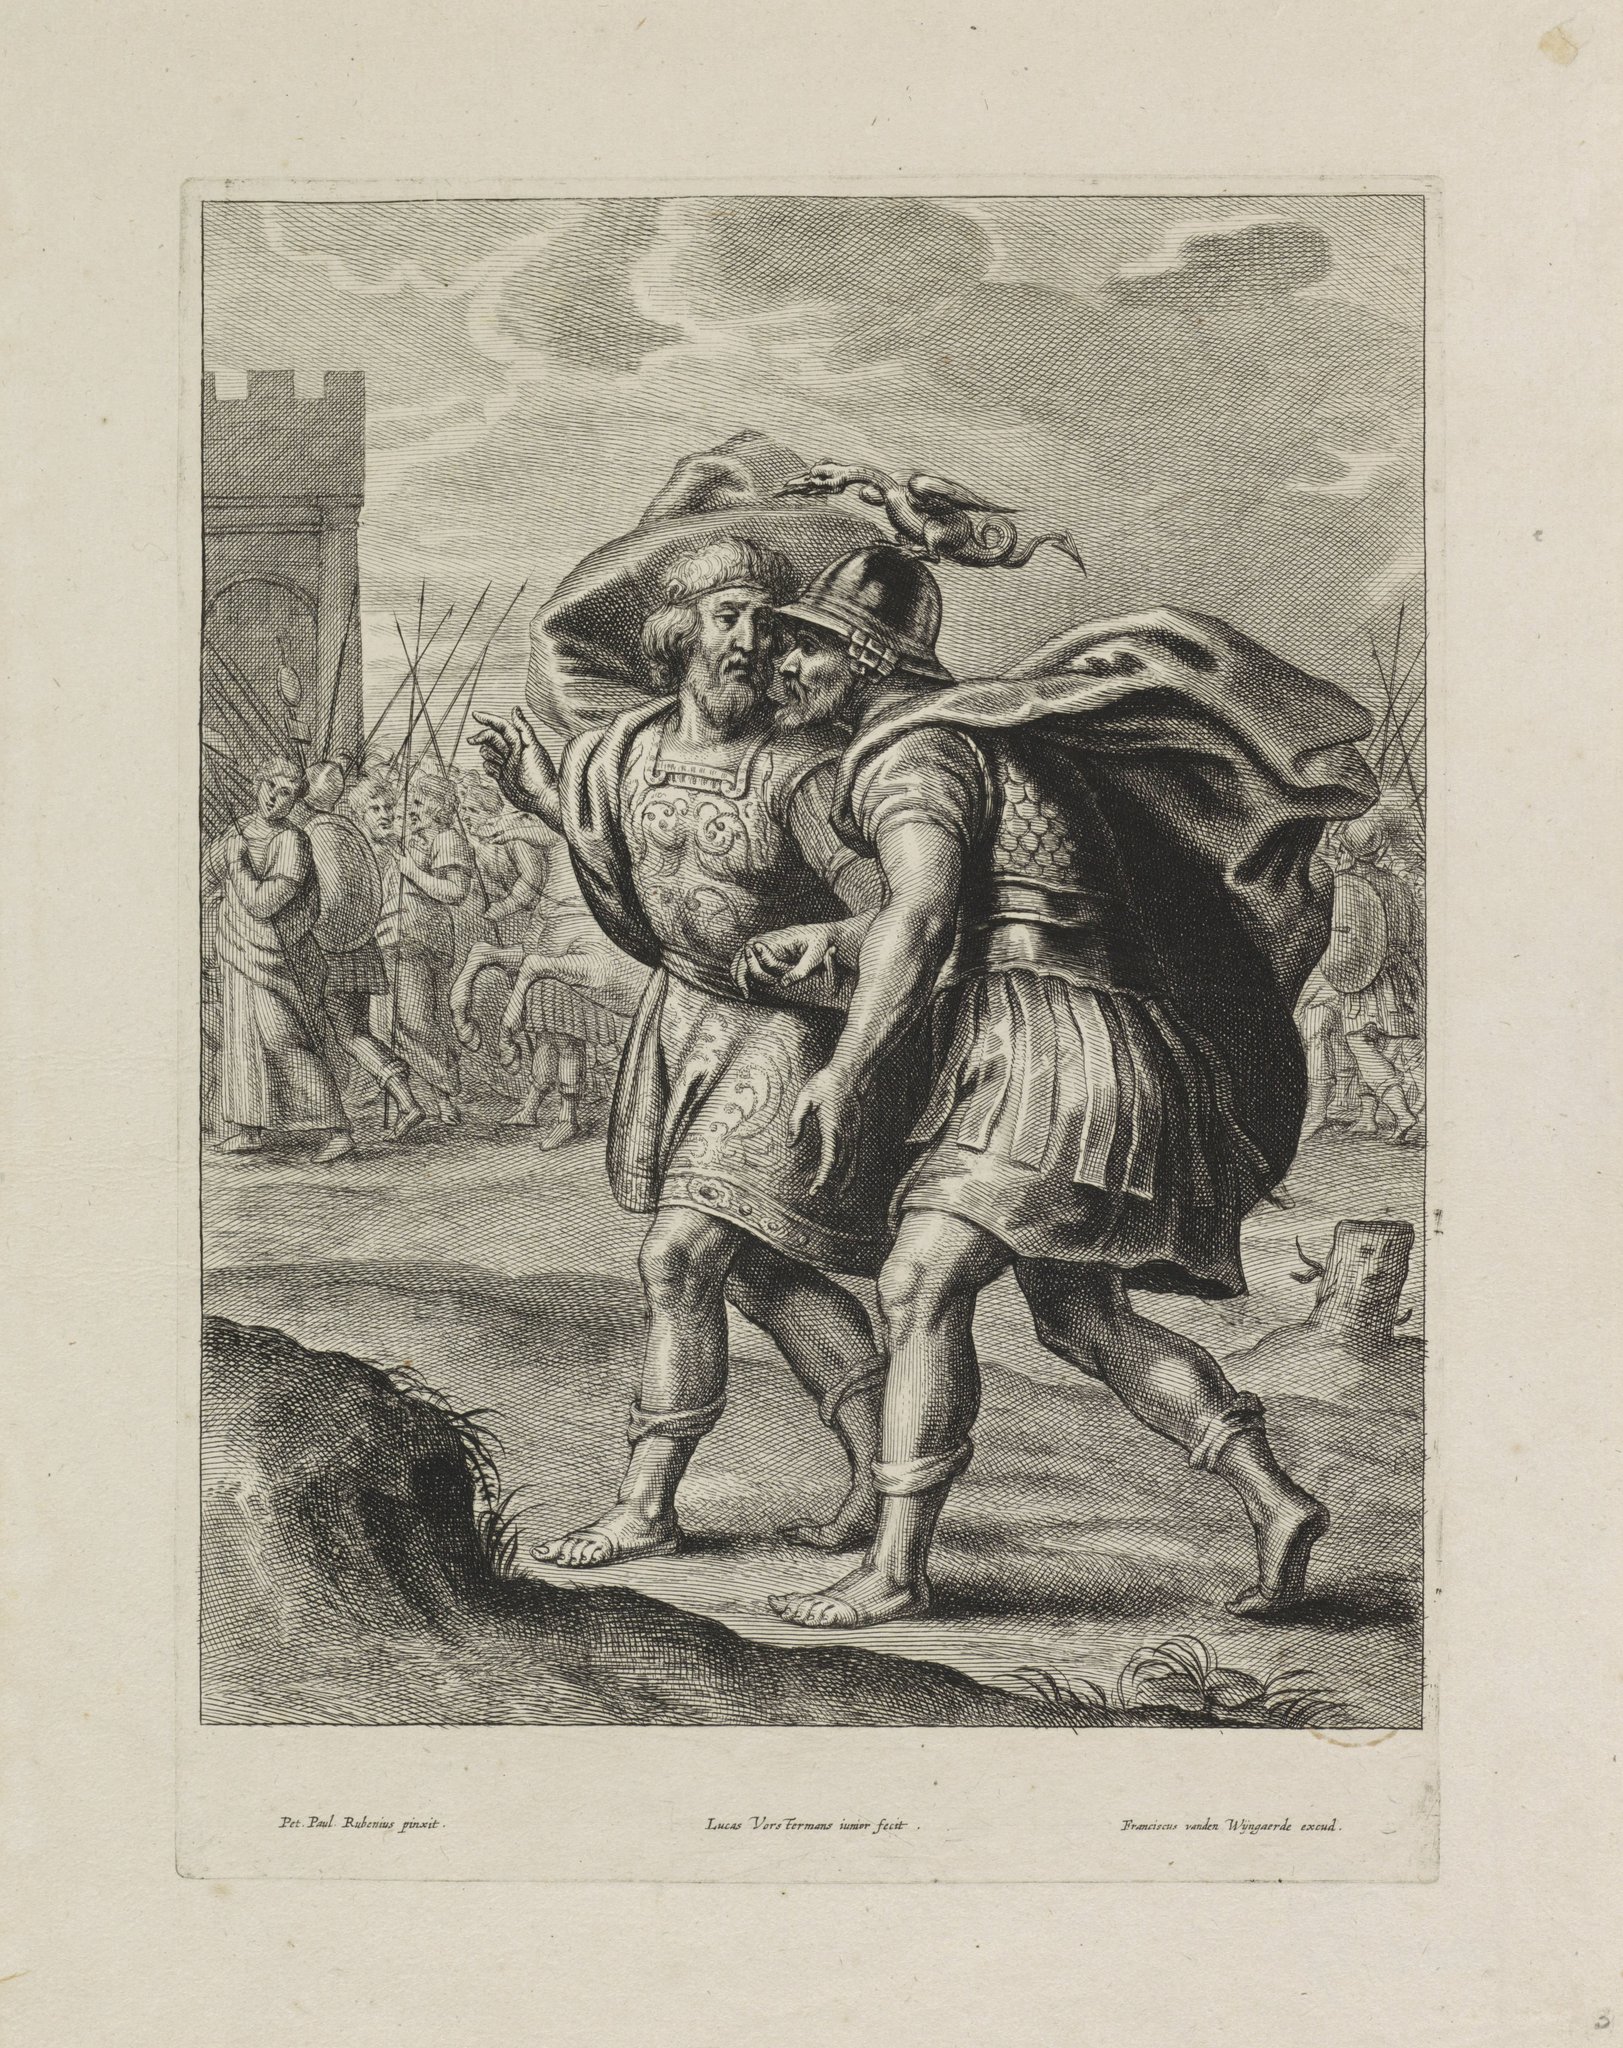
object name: print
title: Anchises voorspelt de geschiedenis van Rome aan Aeneas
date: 1651-1679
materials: paper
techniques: engraving, etching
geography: antwerp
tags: anchises foretells the history of rome to aeneas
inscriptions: collector's mark: Lugt 240